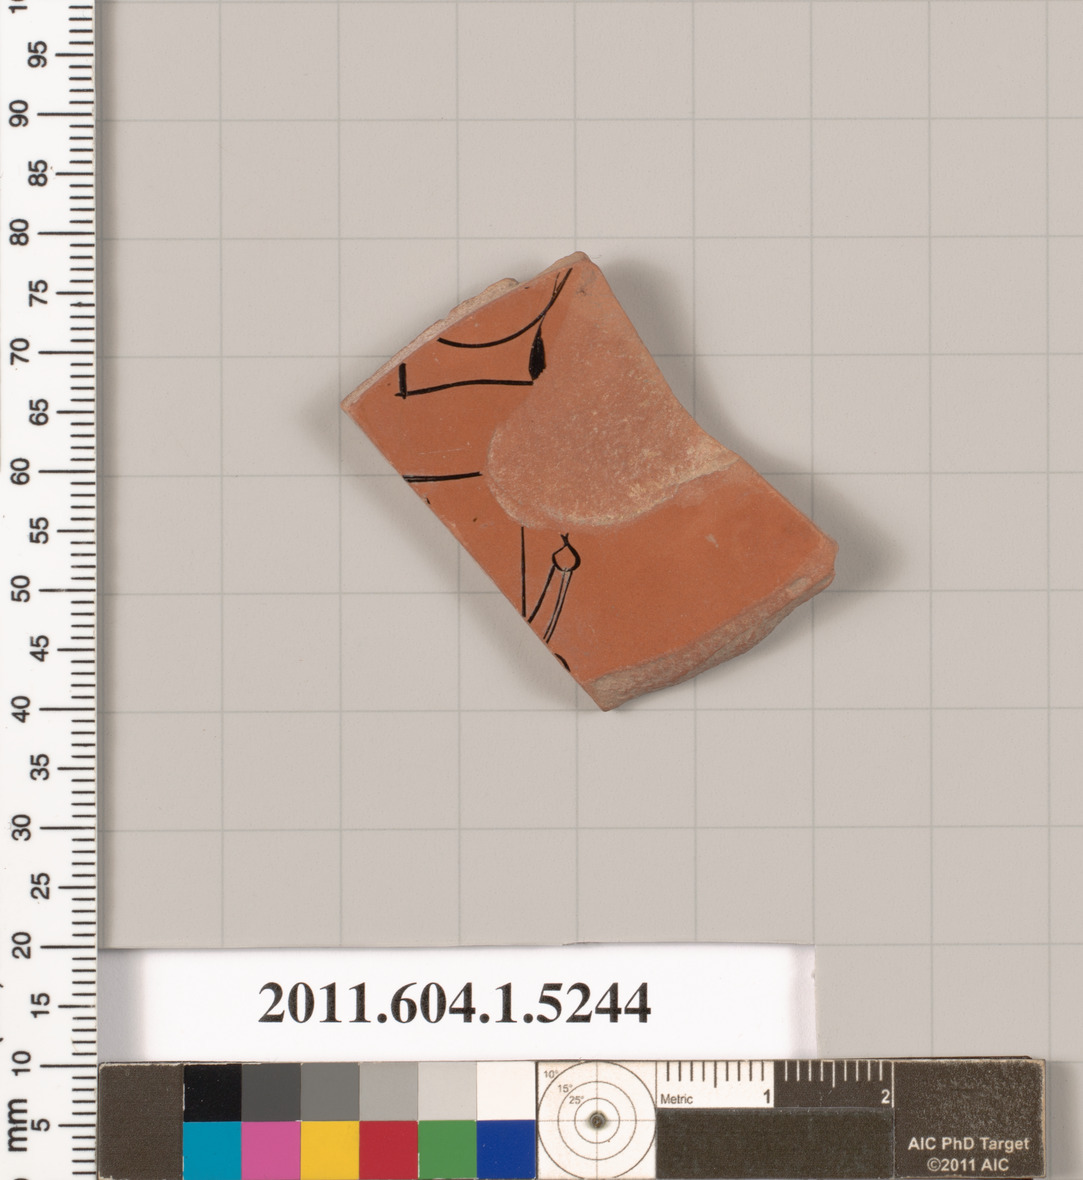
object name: kylix fragment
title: Terracotta fragment of a kylix (drinking cup)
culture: greek, attic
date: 520-510 BCE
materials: terracotta